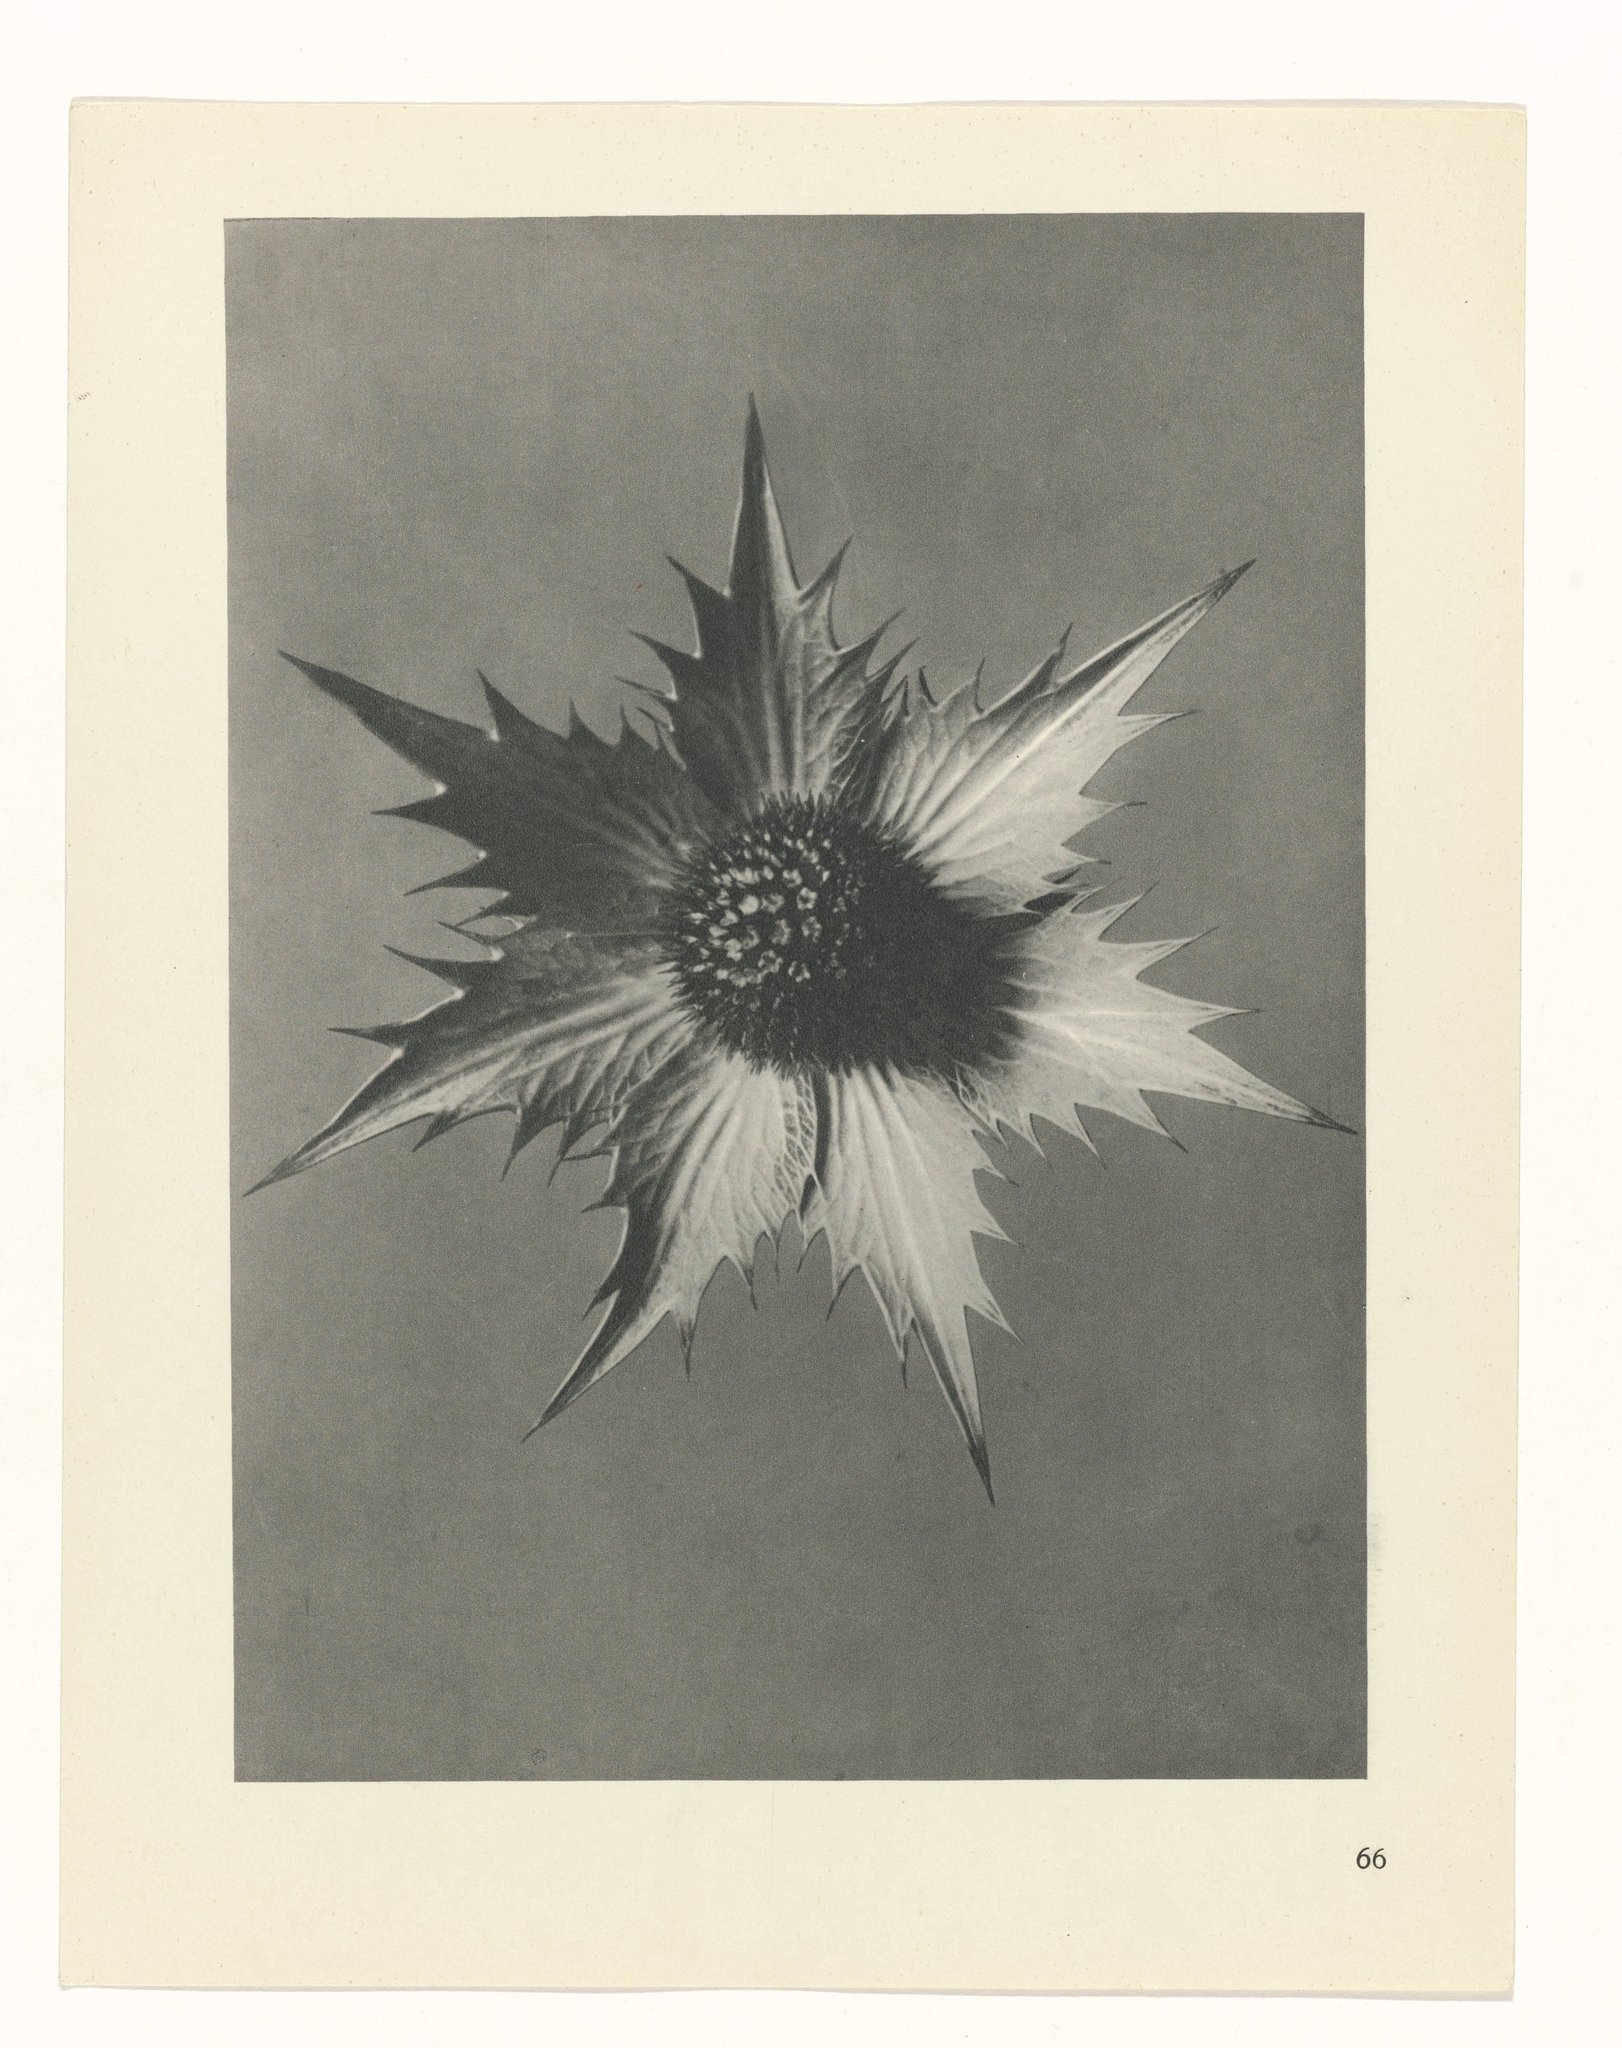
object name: photograph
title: Plantstudie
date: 1928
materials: ink, paper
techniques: rotogravure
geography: berlin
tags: plants (in general)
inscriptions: number: ‘66’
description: facher Vergrößerung. Afkomstig uit losbladige uitgave.